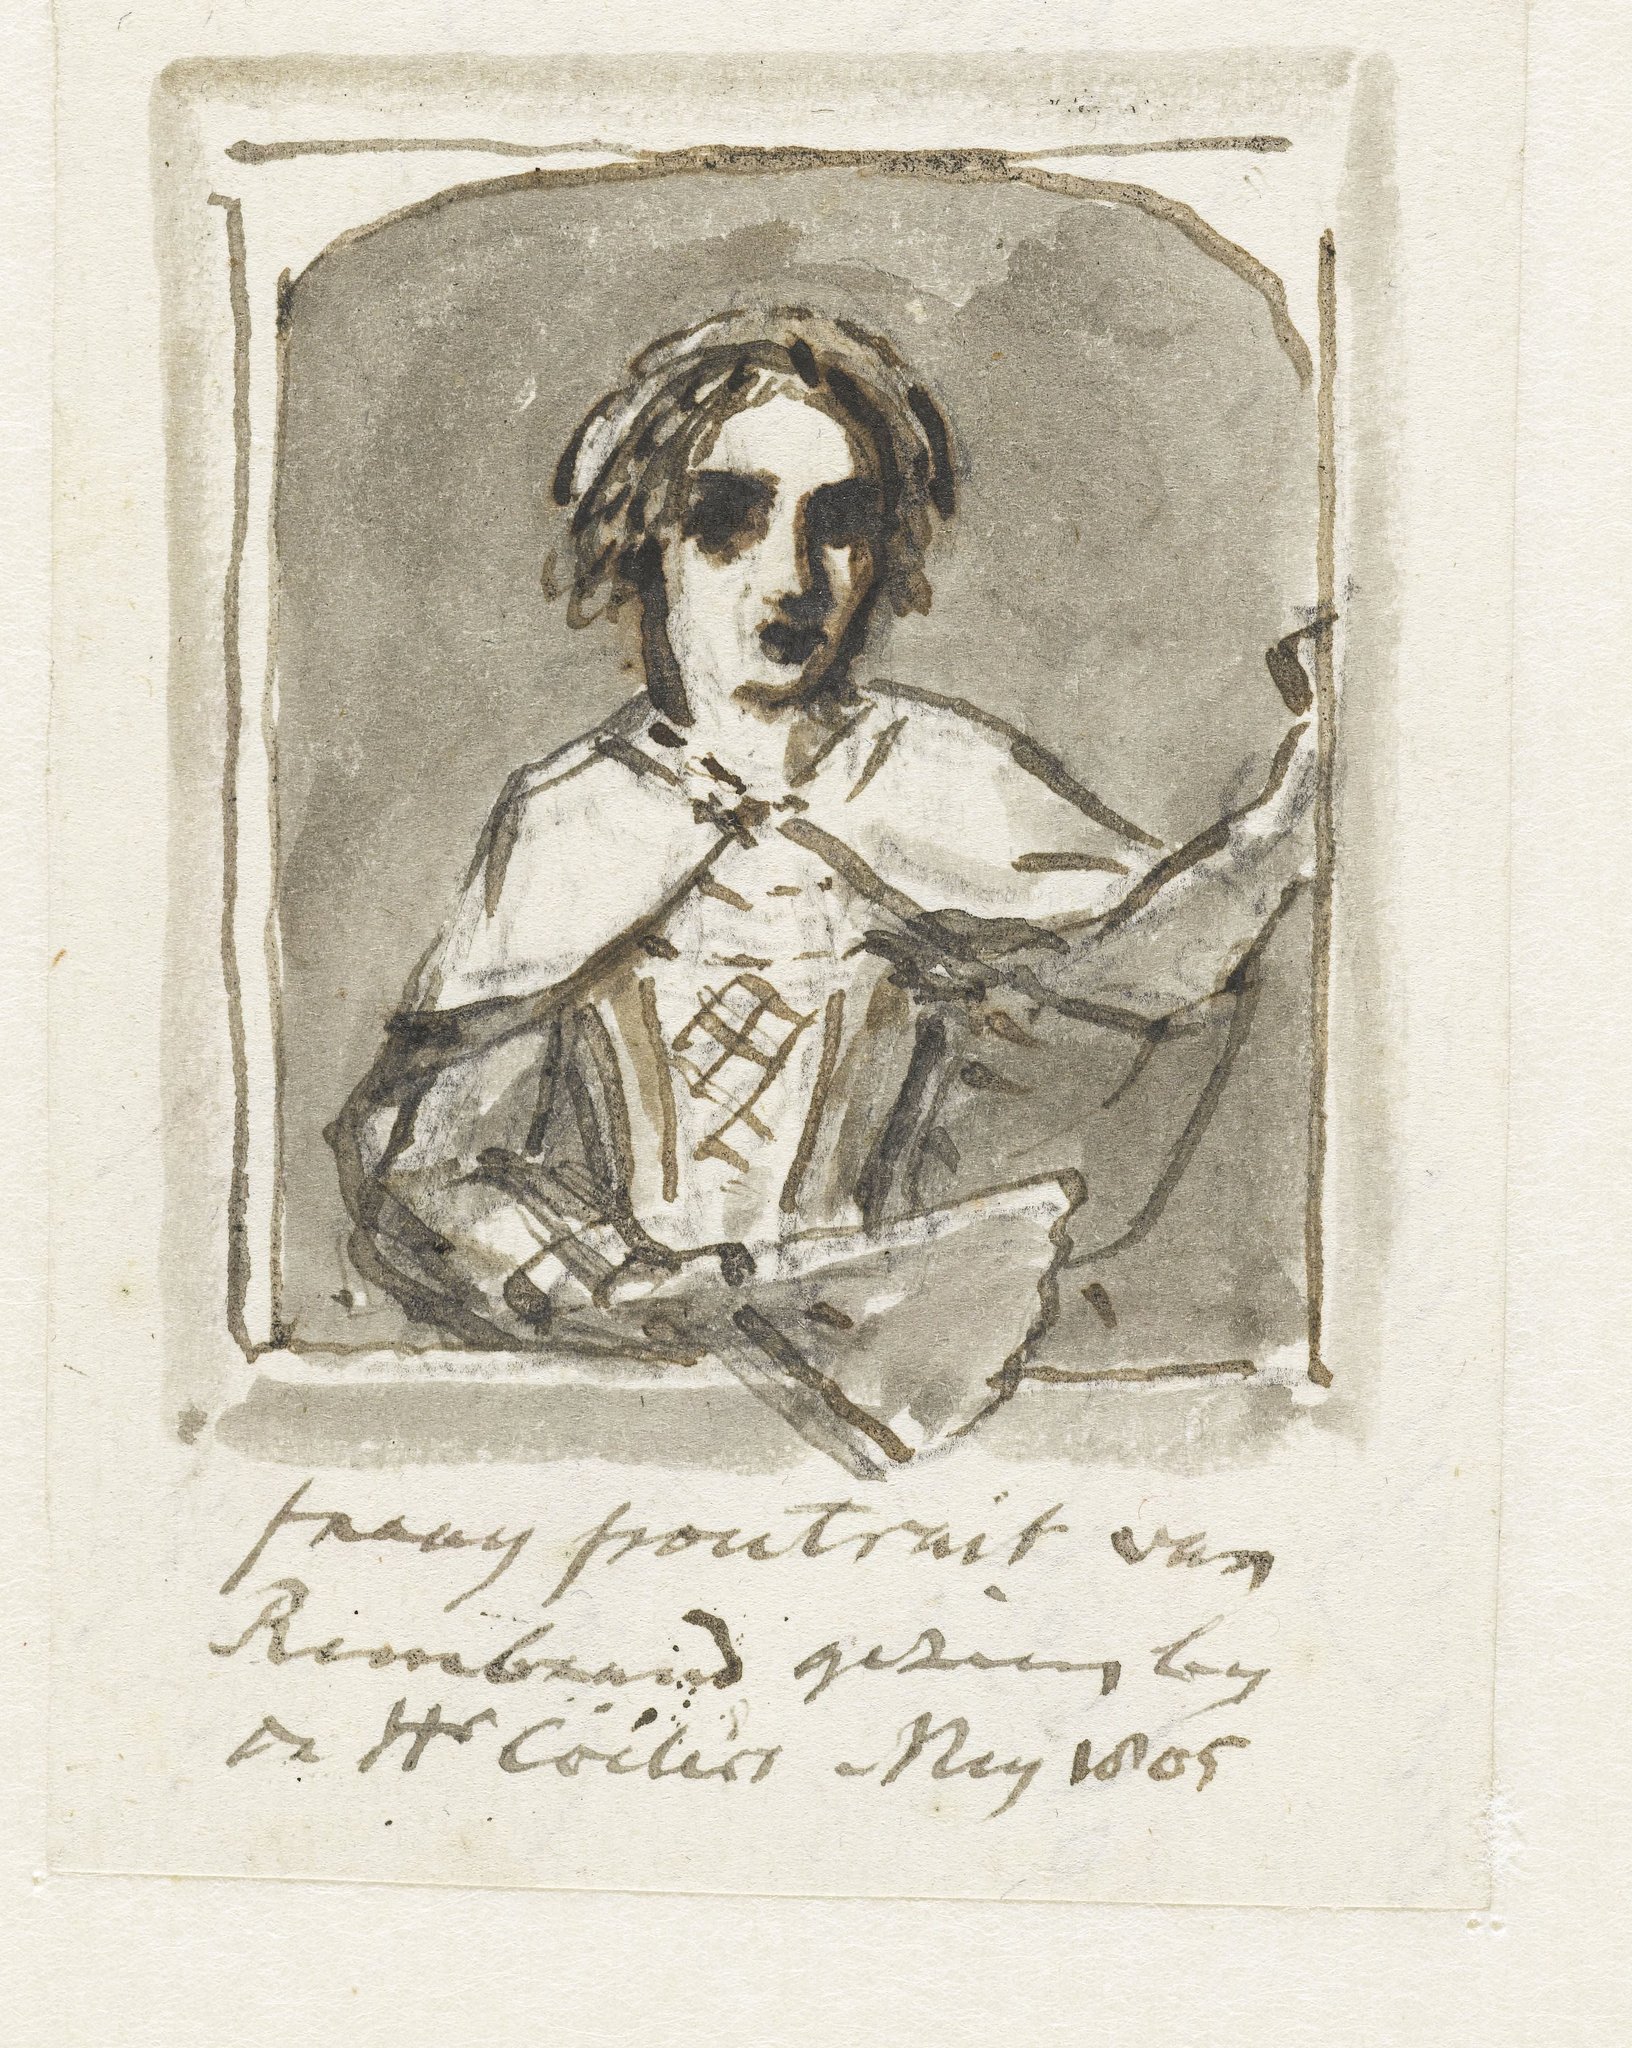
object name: drawing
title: Portret van een vrouw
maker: jurriaan andriessen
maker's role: draughtsman, painter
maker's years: 1742-1819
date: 1805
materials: graphite, ink, paper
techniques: brush, pen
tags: anonymous historical person portrayed alone, picture, painting